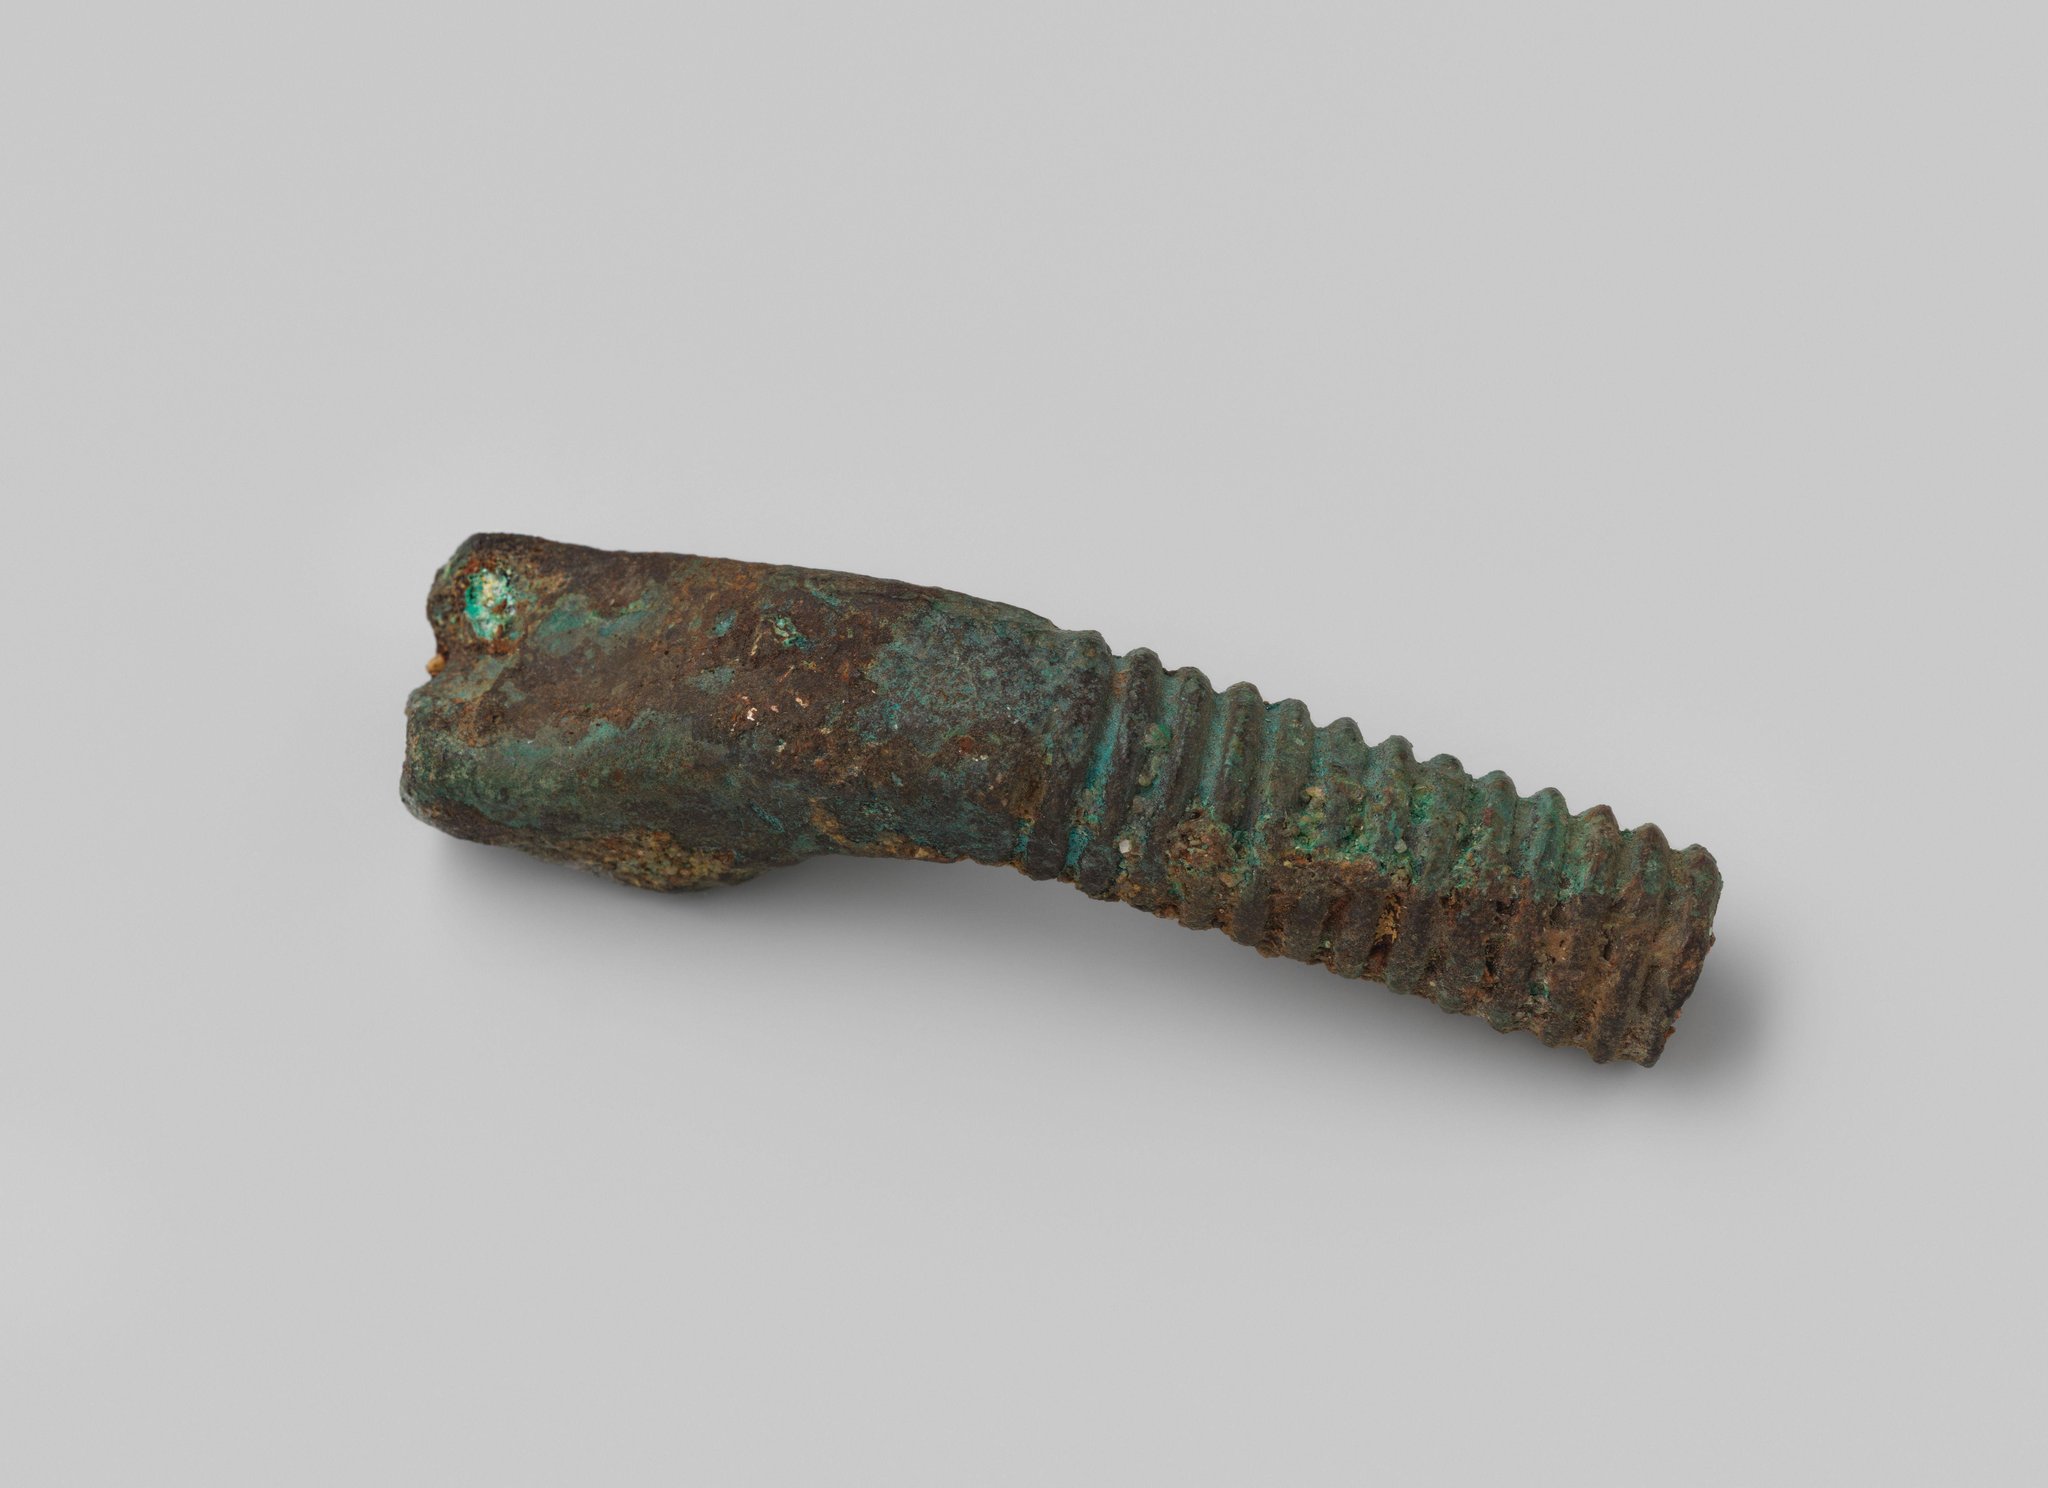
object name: bolt tongs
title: Bout afkomstig uit het wrak van de Oost-Indiëvaarder Hollandia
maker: Anonymous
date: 1700-1743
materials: bronze, copper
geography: netherlands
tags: verenigde oostindische compagnie, hollandia (schip)